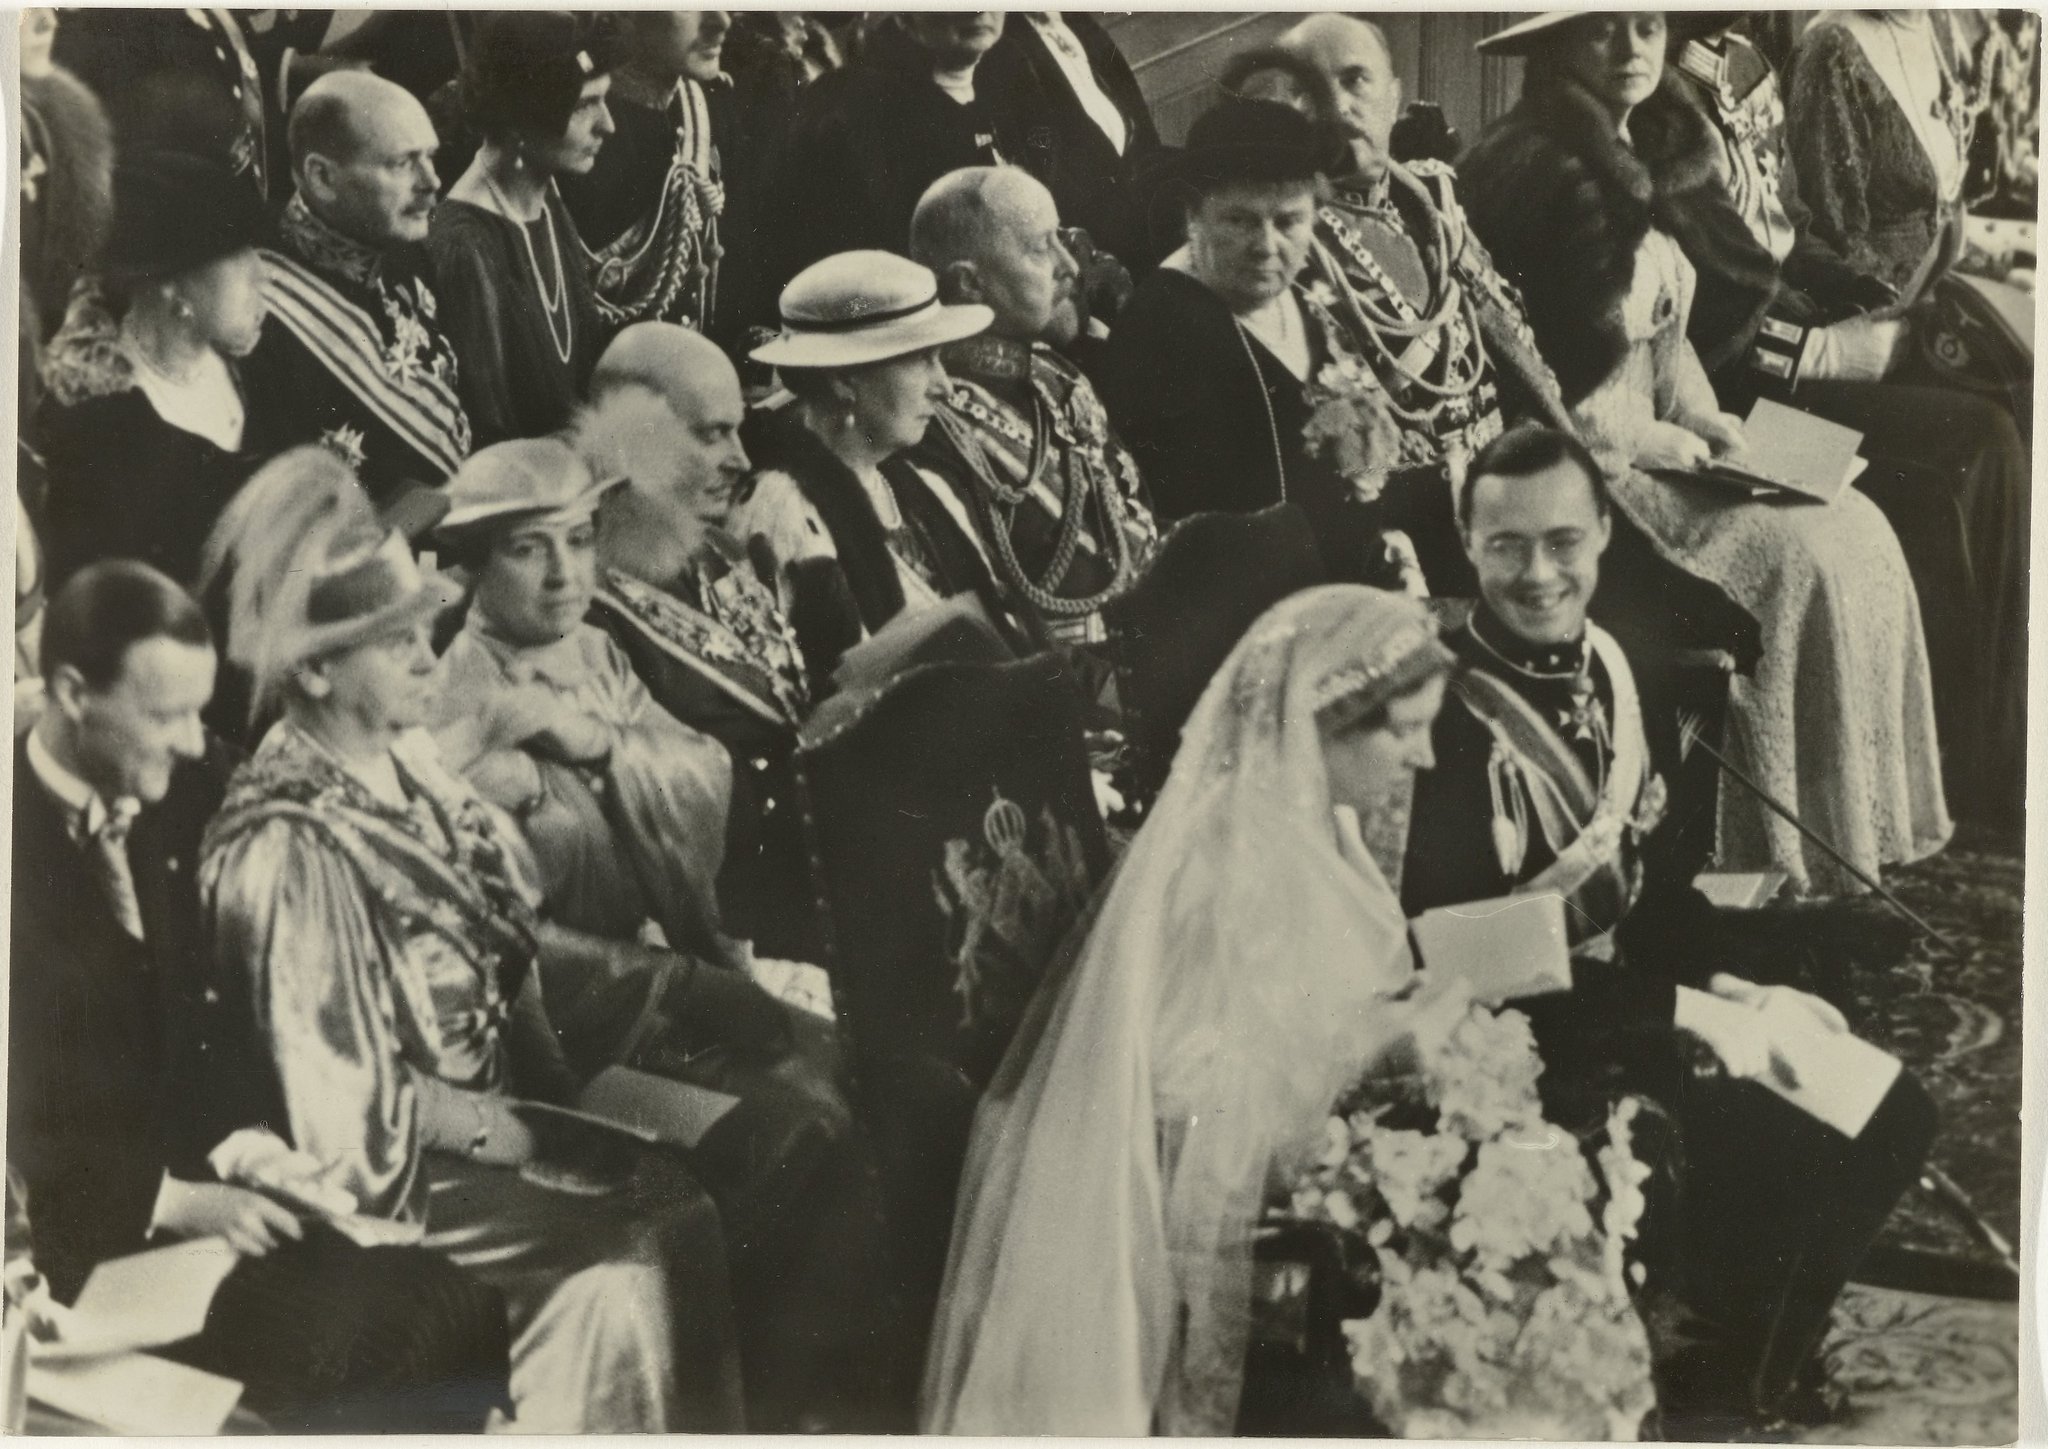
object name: ansichtkaart, prentbriefkaart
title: Inzegening van het huwelijk van prinses Juliana en prins Bernhard in de St. Jacobskerk in Den Haag, 7 januari 1937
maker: erich salomon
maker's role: fotograaf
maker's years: 1886-1944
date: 1937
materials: paper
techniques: gelatin silver print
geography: the hague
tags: utrecht, bernhard (prins der nederlanden), juliana of the netherlands, marriage ~ protestant service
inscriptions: annotation: ‘DE INZEGENING // van // HET HUWELIJK // van Hunne Koninklijke Hoogheden // PRINSES JULIANA EN PRINS BERNHARD // in de St. Jacobskerk te 's Gravenhage // 7 Januari 1937 // UITGAVE VAN WEEKBLAD "HET LEVEN" // Copyright Dr. Erich Salomon’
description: Eén van 10 prentbriefkaarten in een mapje.